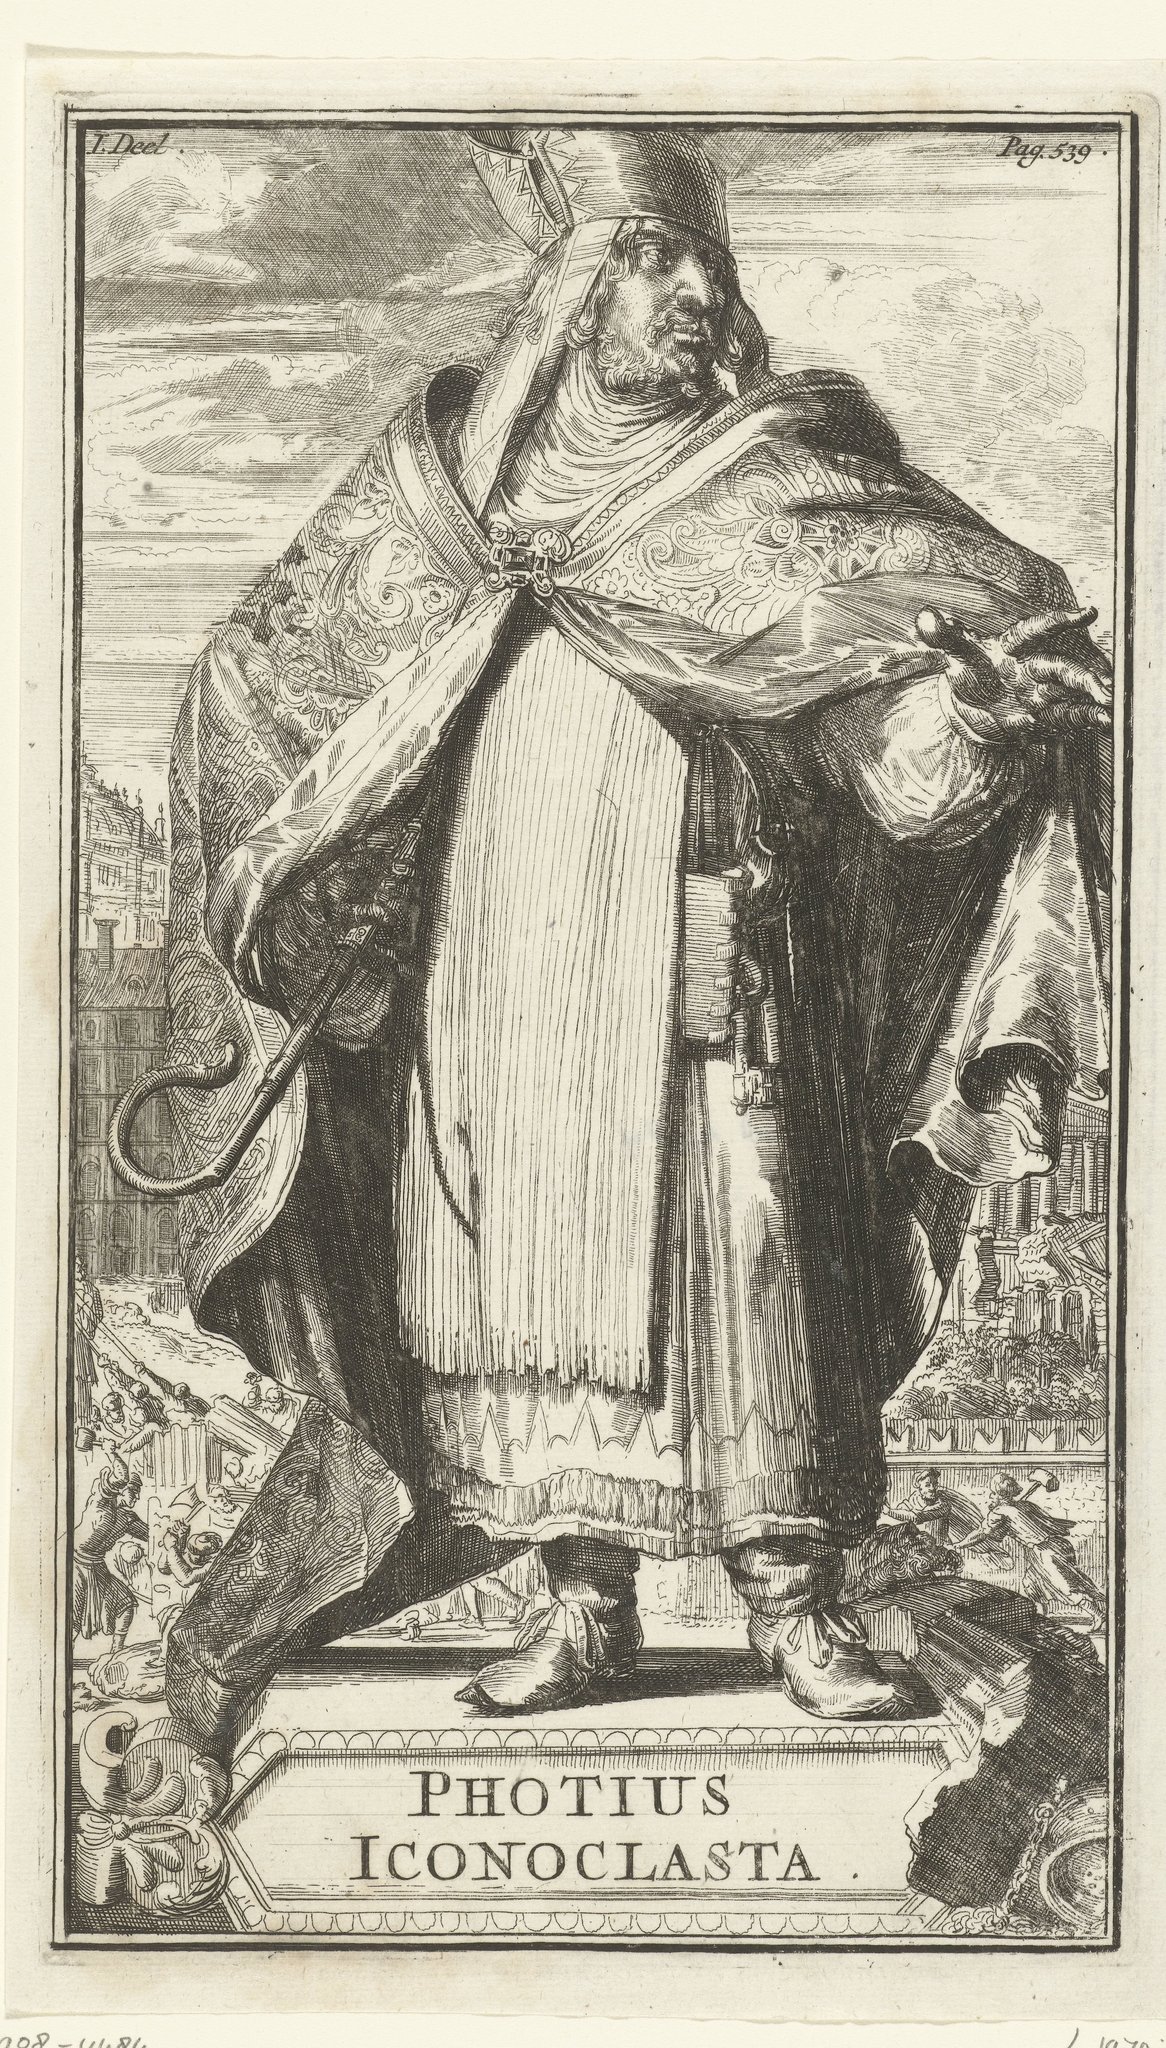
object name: print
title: Historie der Kerken en ketteren (...) tot aan het jaar onses Heeren 1688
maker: romeyn de hooghe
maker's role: draughtsman, goldsmith, painter, print maker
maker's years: 1645-1708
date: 1701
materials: paper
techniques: engraving, etching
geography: netherlands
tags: geleerde, photius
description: Portret van Photius Icononclasta uit een serie portretten in Historie der Kerken en ketteren van den beginne des Nieuwen Testaments tot aan het jaar onses Heeren 1688 van Godfried Arnold (1701).